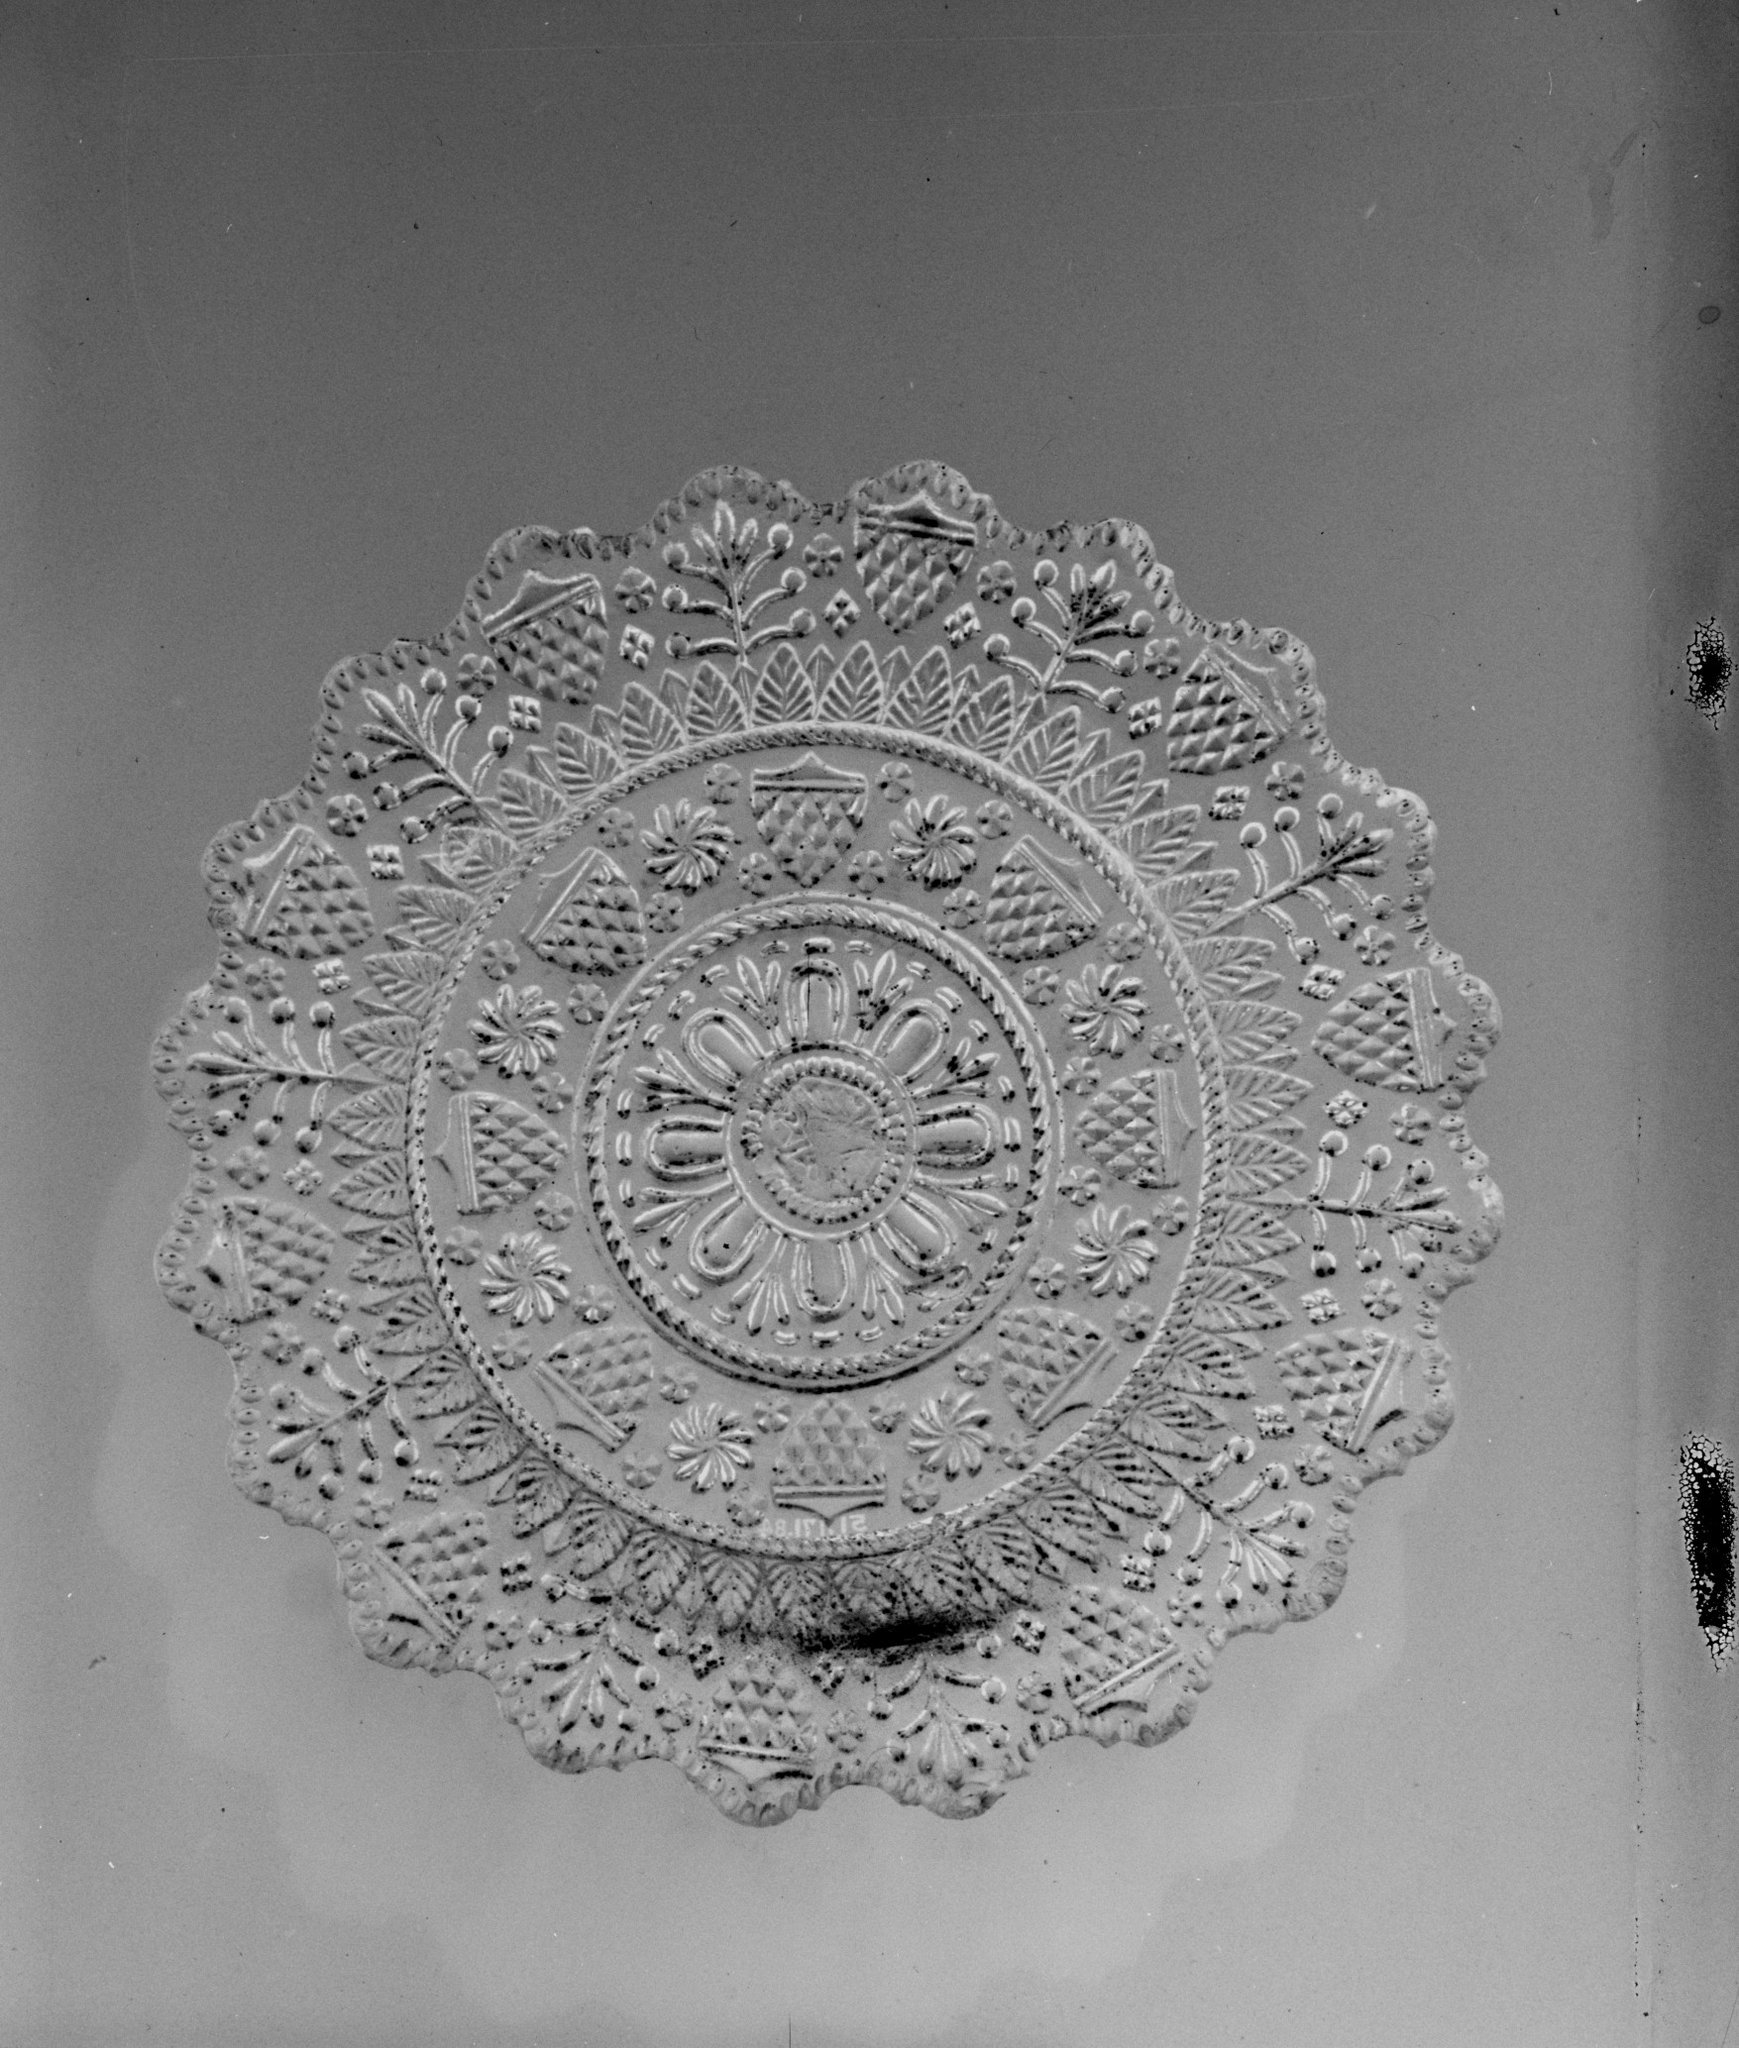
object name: plate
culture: american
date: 1830-1835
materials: glass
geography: united states